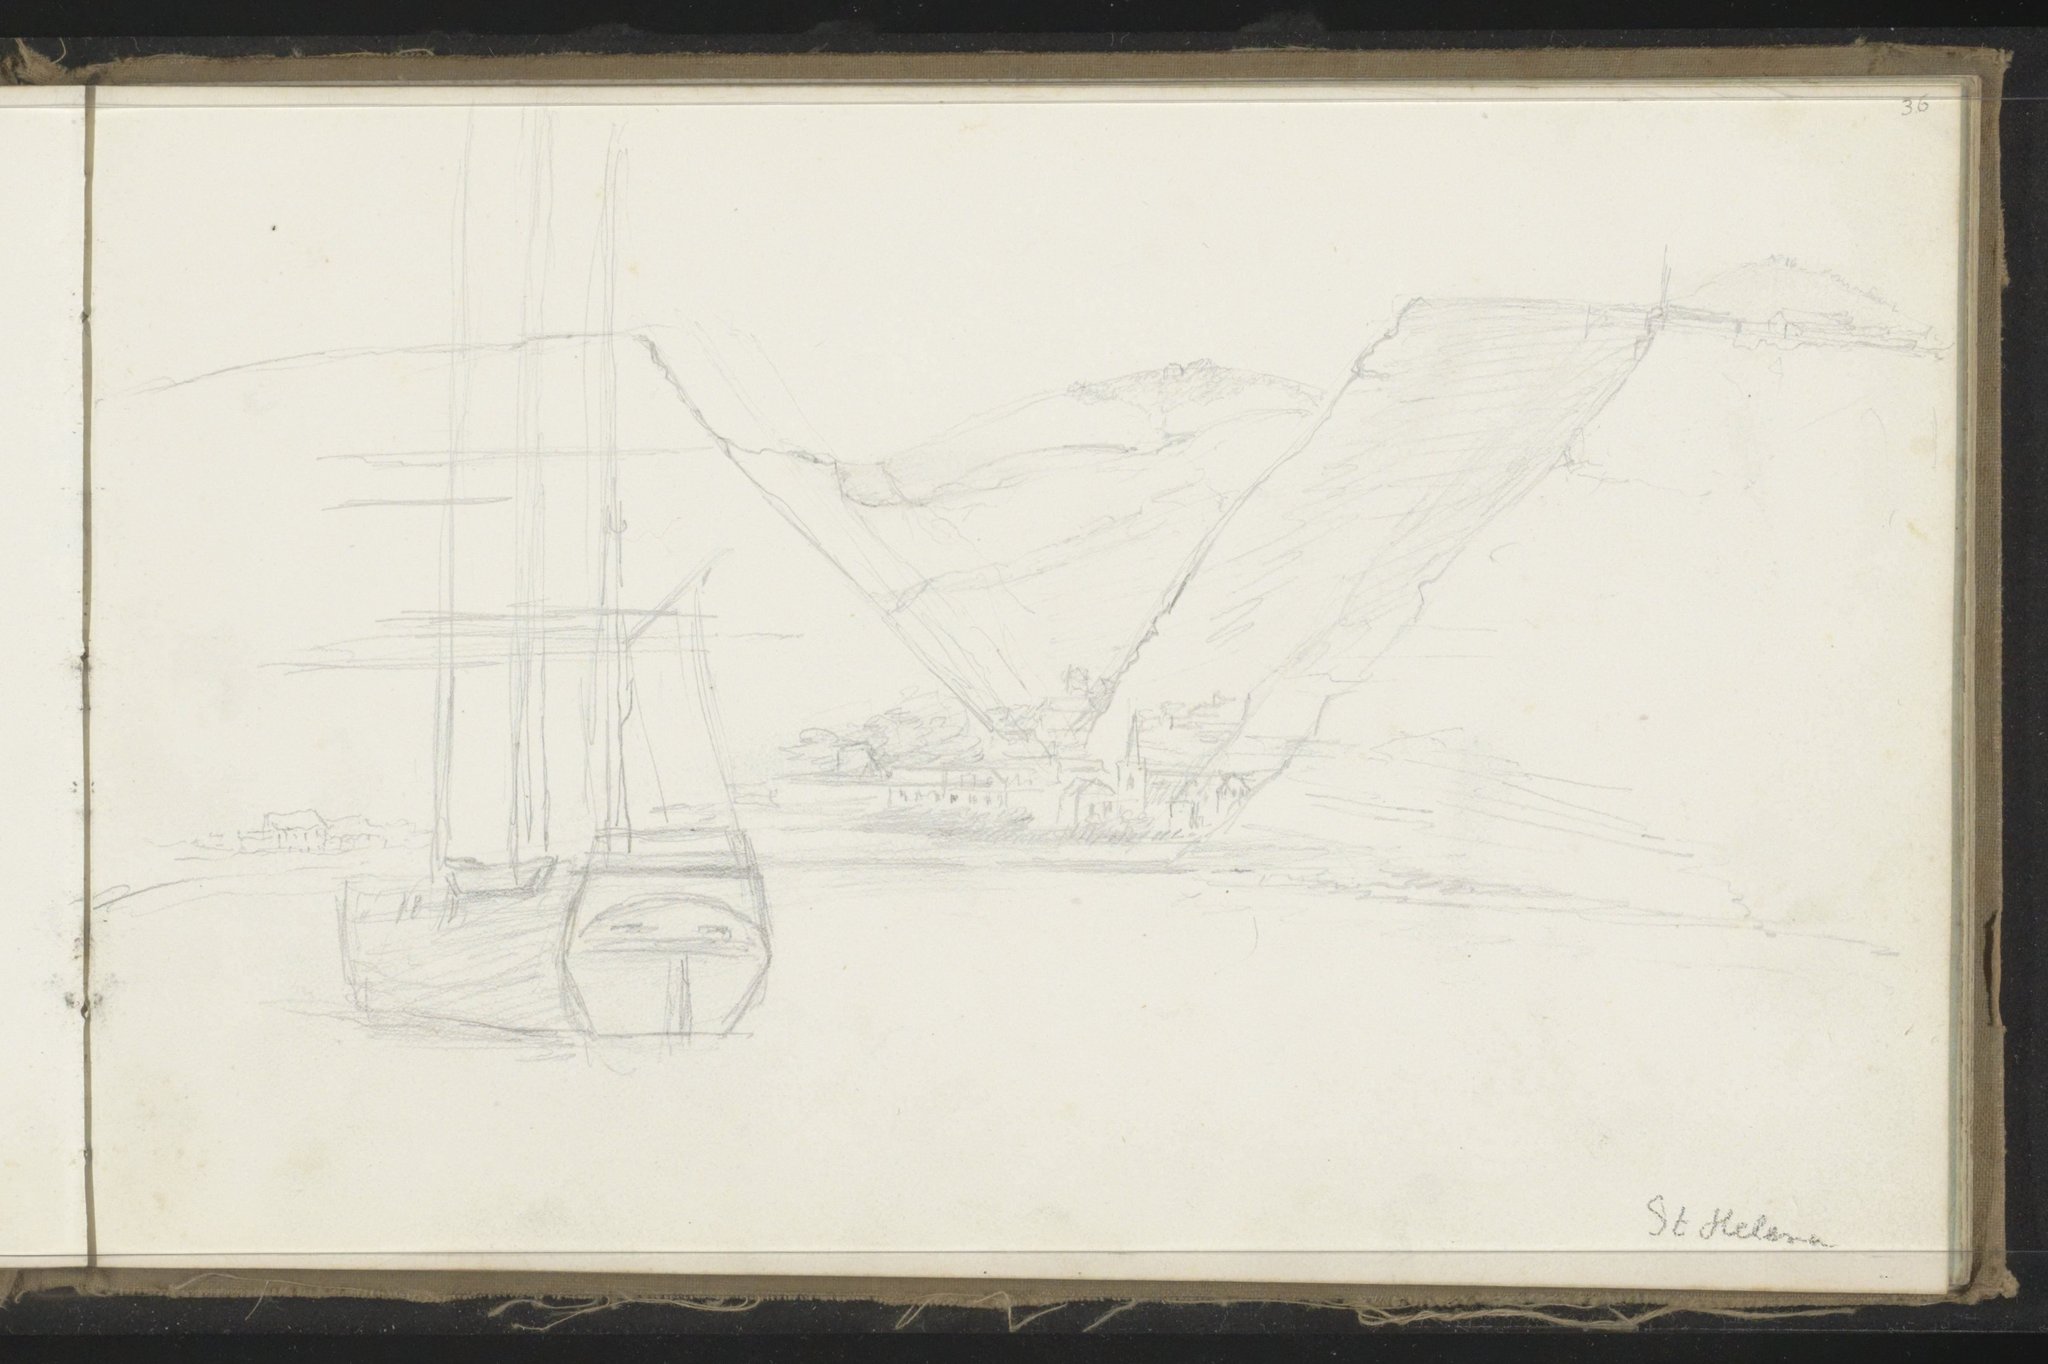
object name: sketchbook leaf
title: Zeilschip voor de kust van Sint-Helena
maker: christian heinrich gottlieb steuerwald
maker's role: draughtsman, print maker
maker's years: 1802-1874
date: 1848-1854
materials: paper, pencil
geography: sint-helena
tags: city-view, and landscape with man-made constructions, sailing-ship, sailing-boat, mountains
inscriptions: date and inscription: ‘St Helena’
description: Blad 36 recto uit een schetsboek met 58 bladen.